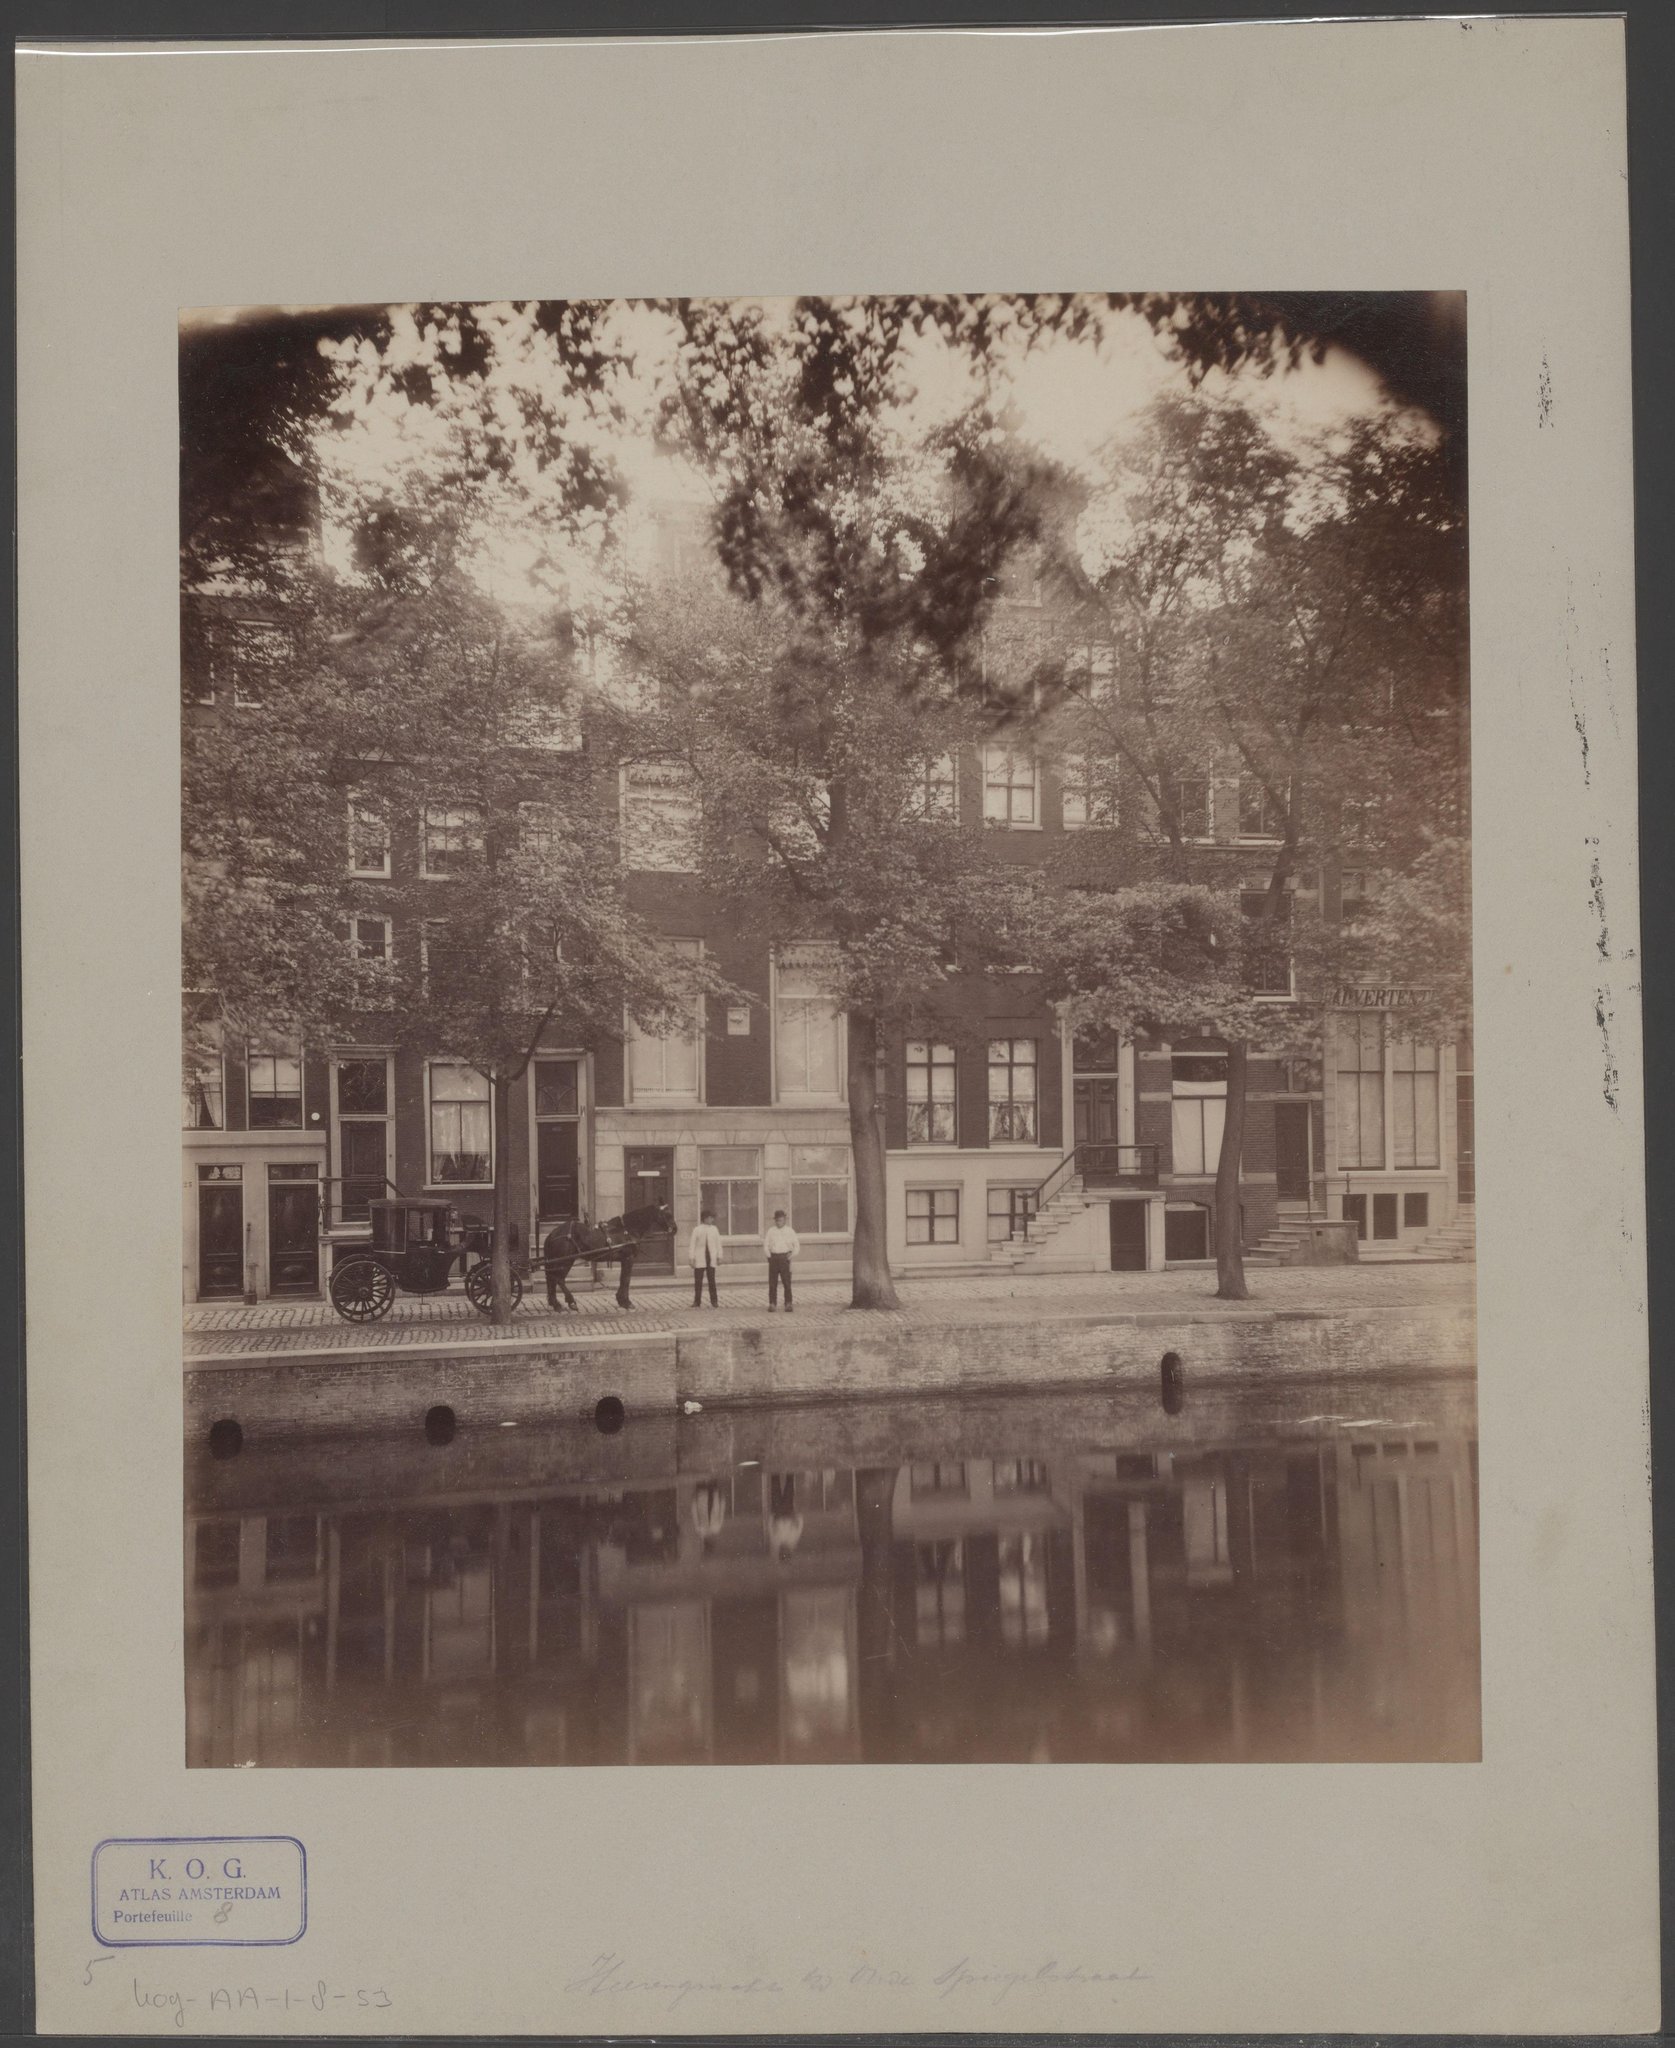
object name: photograph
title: Gezicht op de Herengracht bij de Oude Spiegelstraat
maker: johannes petrus oppers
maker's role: fotograaf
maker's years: 1833-1890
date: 1859-1890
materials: cardboard, paper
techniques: albumen print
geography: amsterdam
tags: city-view in general; 'veduta', canal, the usual house or row of houses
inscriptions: inscription: ‘Heerengracht bij oude Spiegelstraat’, collector's mark: ‘8’ Lugt 1641b, stamp: ‘Photographisch Atelier / J. P. Oppers / Opvolger H. Sikkes / Singel 40[...] Amsterdam’, inscription: ‘Heerengracht bij de Oude Spiegelstraat. / Amsterdam’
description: Onderwerpsrubriek binnen de Atlas Amsterdam: Haarlemmerplein, Halvemaansteeg, Handboogstraat, Handelskade, Haringpakkerij, Hartenstraat, Hasseltsteeg (Dirk van), Heerengracht.